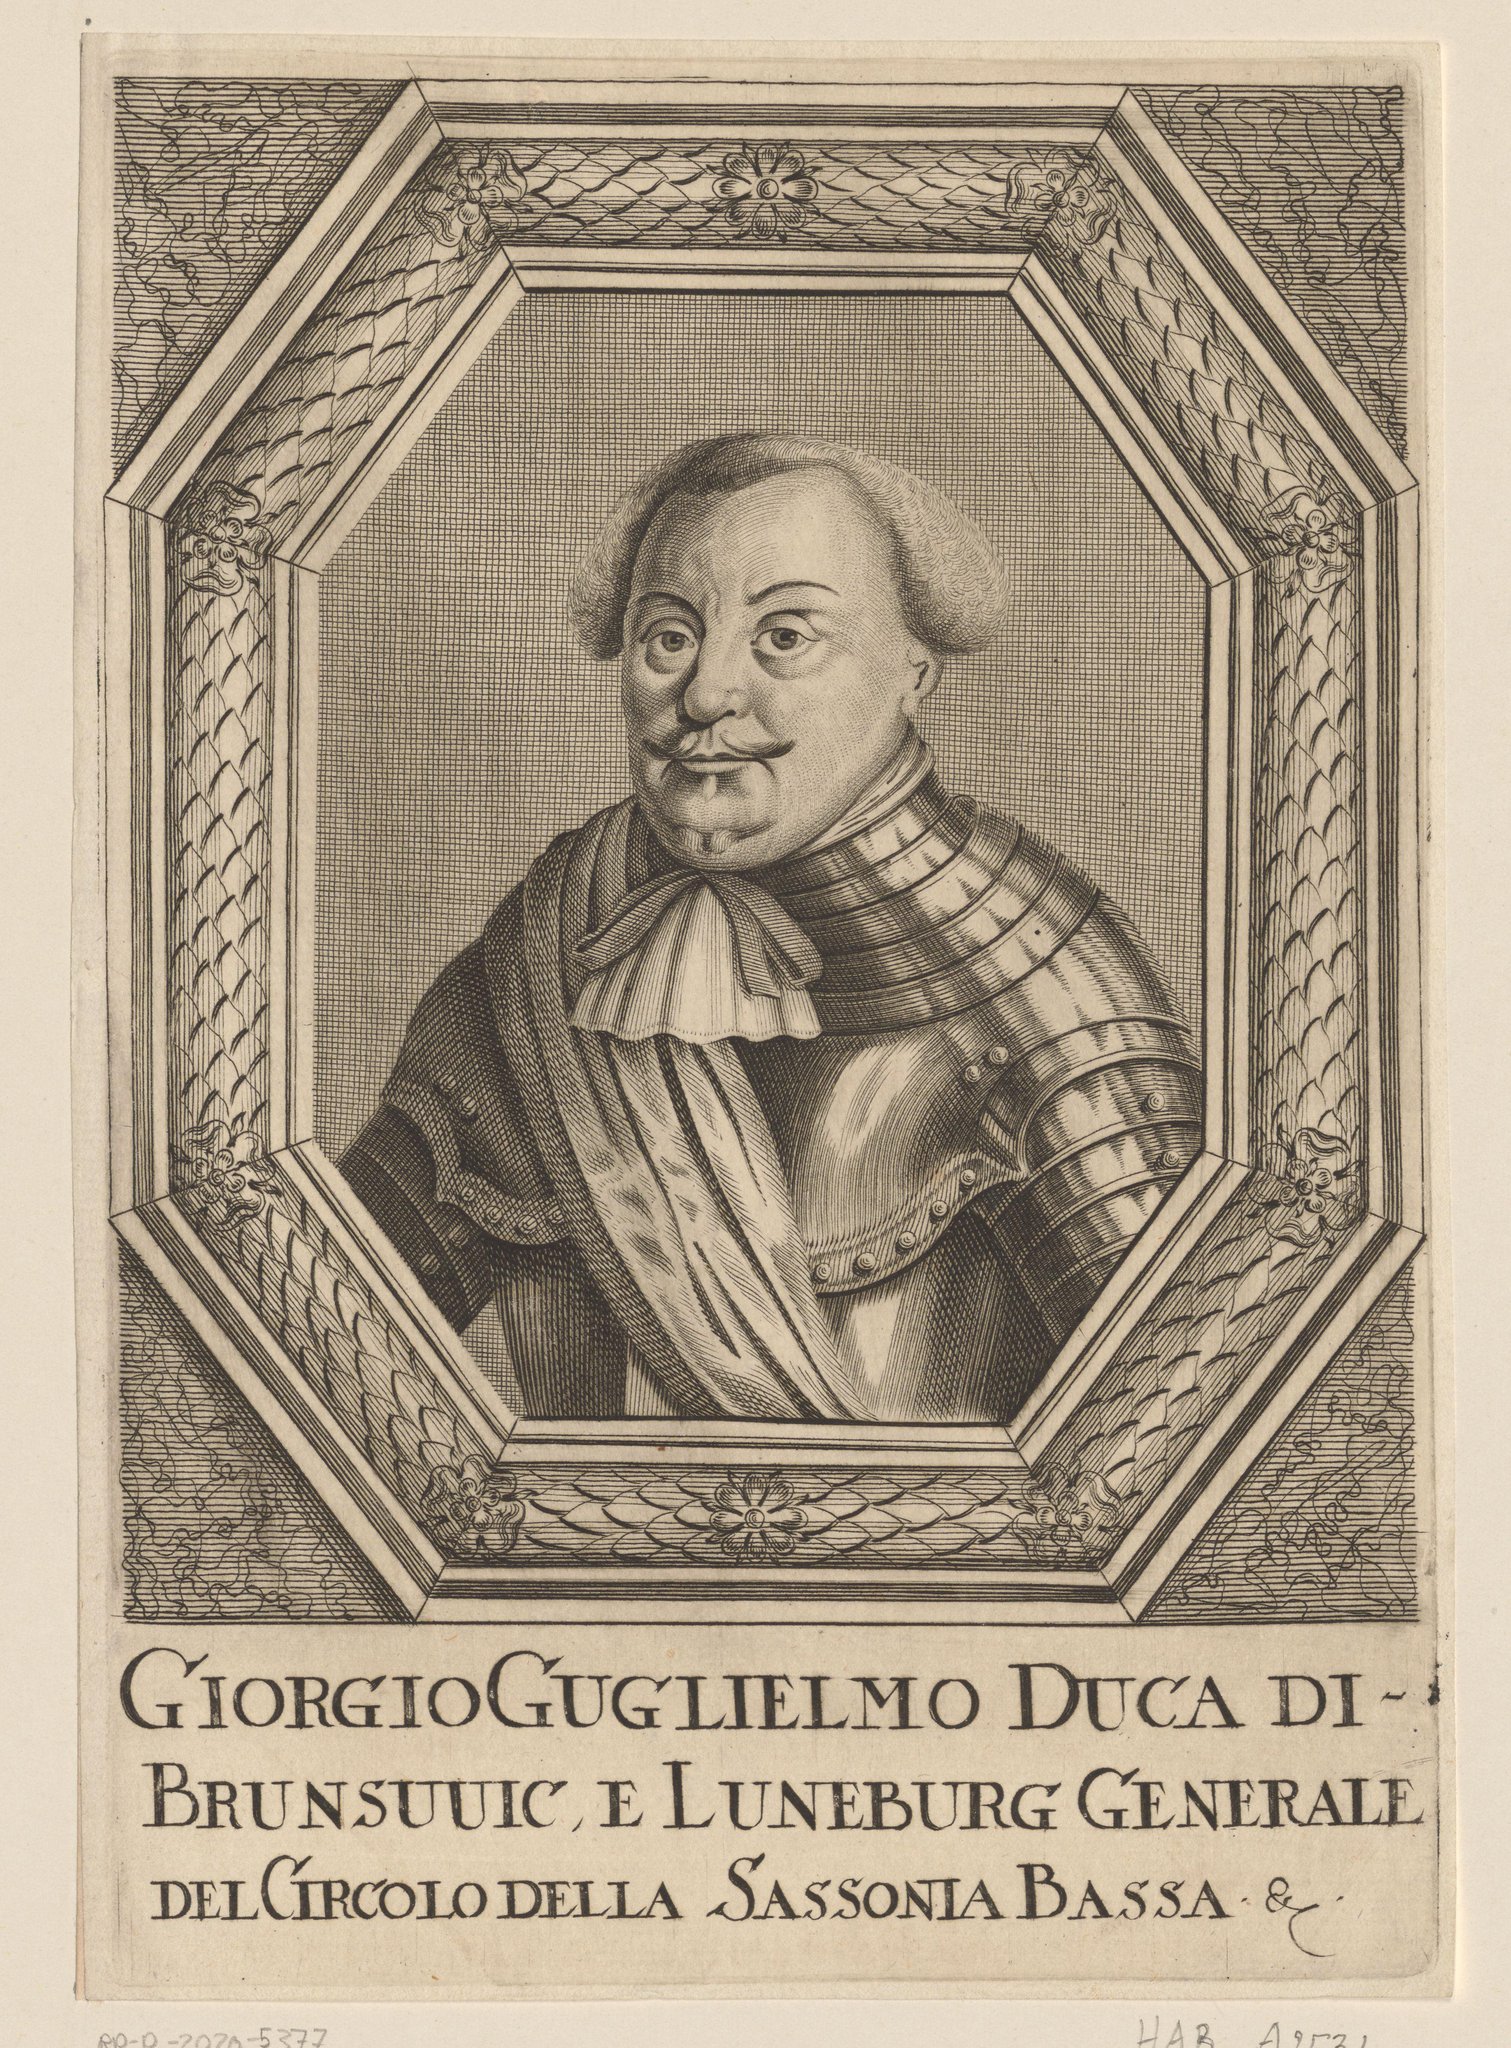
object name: print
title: Portret van Georg von Braunschweig-Lüneburg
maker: Anonymous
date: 1620-1700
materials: paper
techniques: engraving, etching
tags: commander-in-chief, general, marshal, historical persons